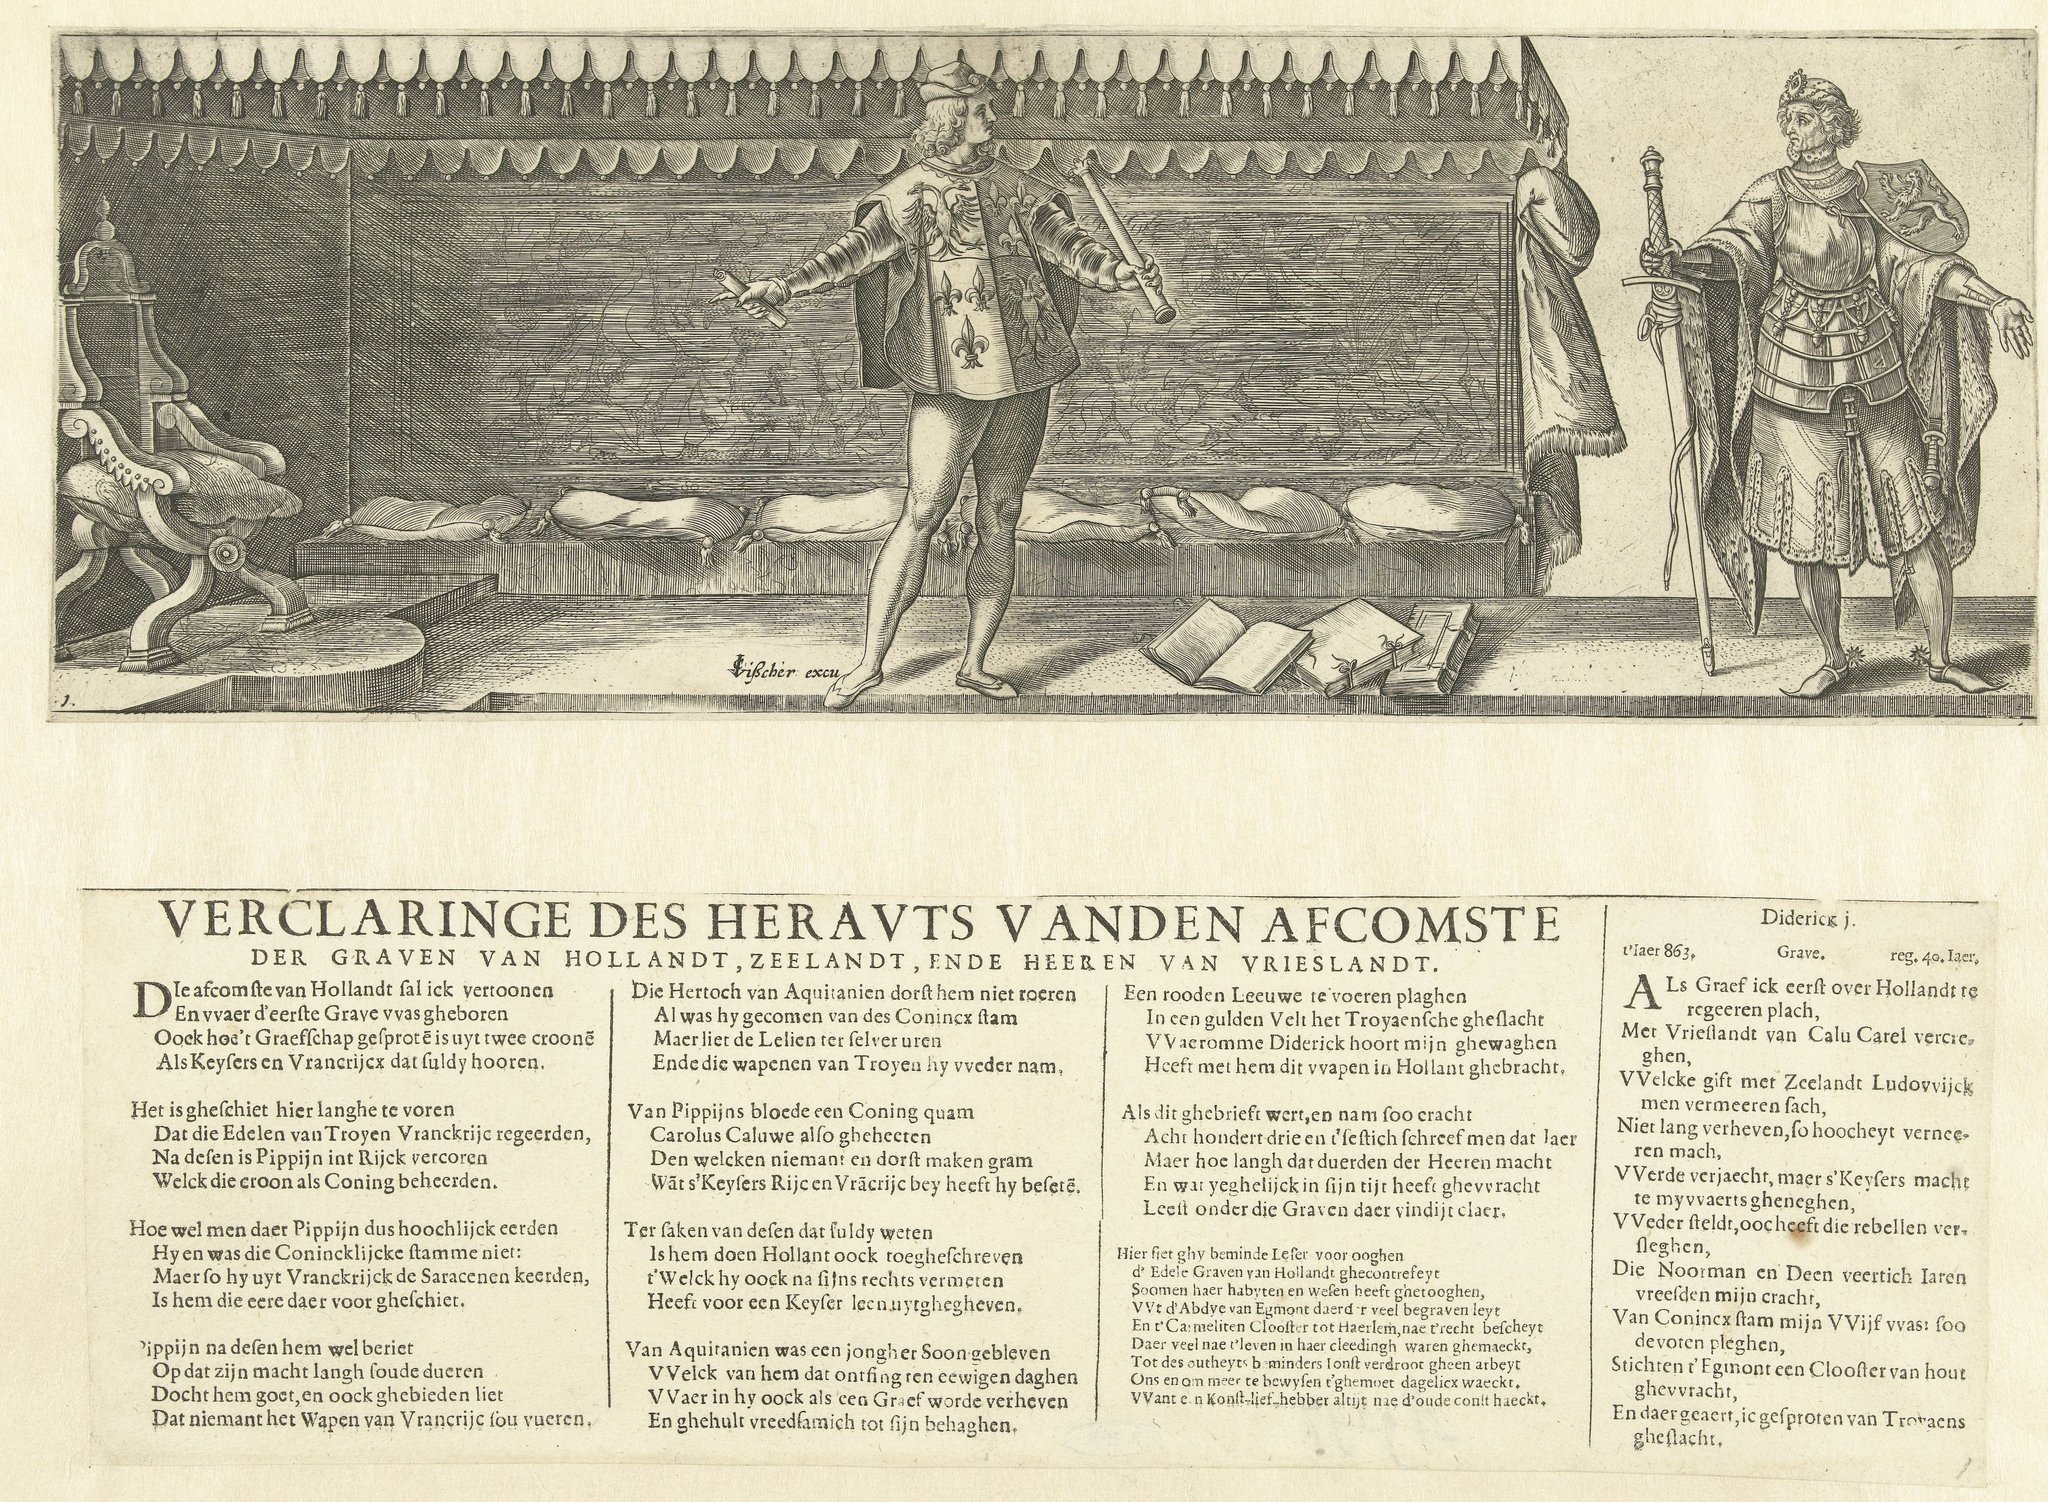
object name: print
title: Graven en gravinnen van Holland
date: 1584-1585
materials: paper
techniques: engraving, letterpress printing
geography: amsterdam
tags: herald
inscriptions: collector's mark: Lugt 2228a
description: Voorstelling van een stoel en een lange bank waarvoor een heraut staat. Naast hem, uiterst rechts, staat een man met zwaard en schild - volgens het bijbehorende onderschrift graaf van Holland Dirk I. Dit is het titelblad voor een serie van acht genummerde prenten van de graven en gravinnen van Holland met bijbehorende verklarende Nederlandse teksten in boekdruk. Prent en tekst zijn steeds op één blad bevestigd. Overigens lijkt er van de jaartallen die in de onderschriften vermeld staan weinig te kloppen.